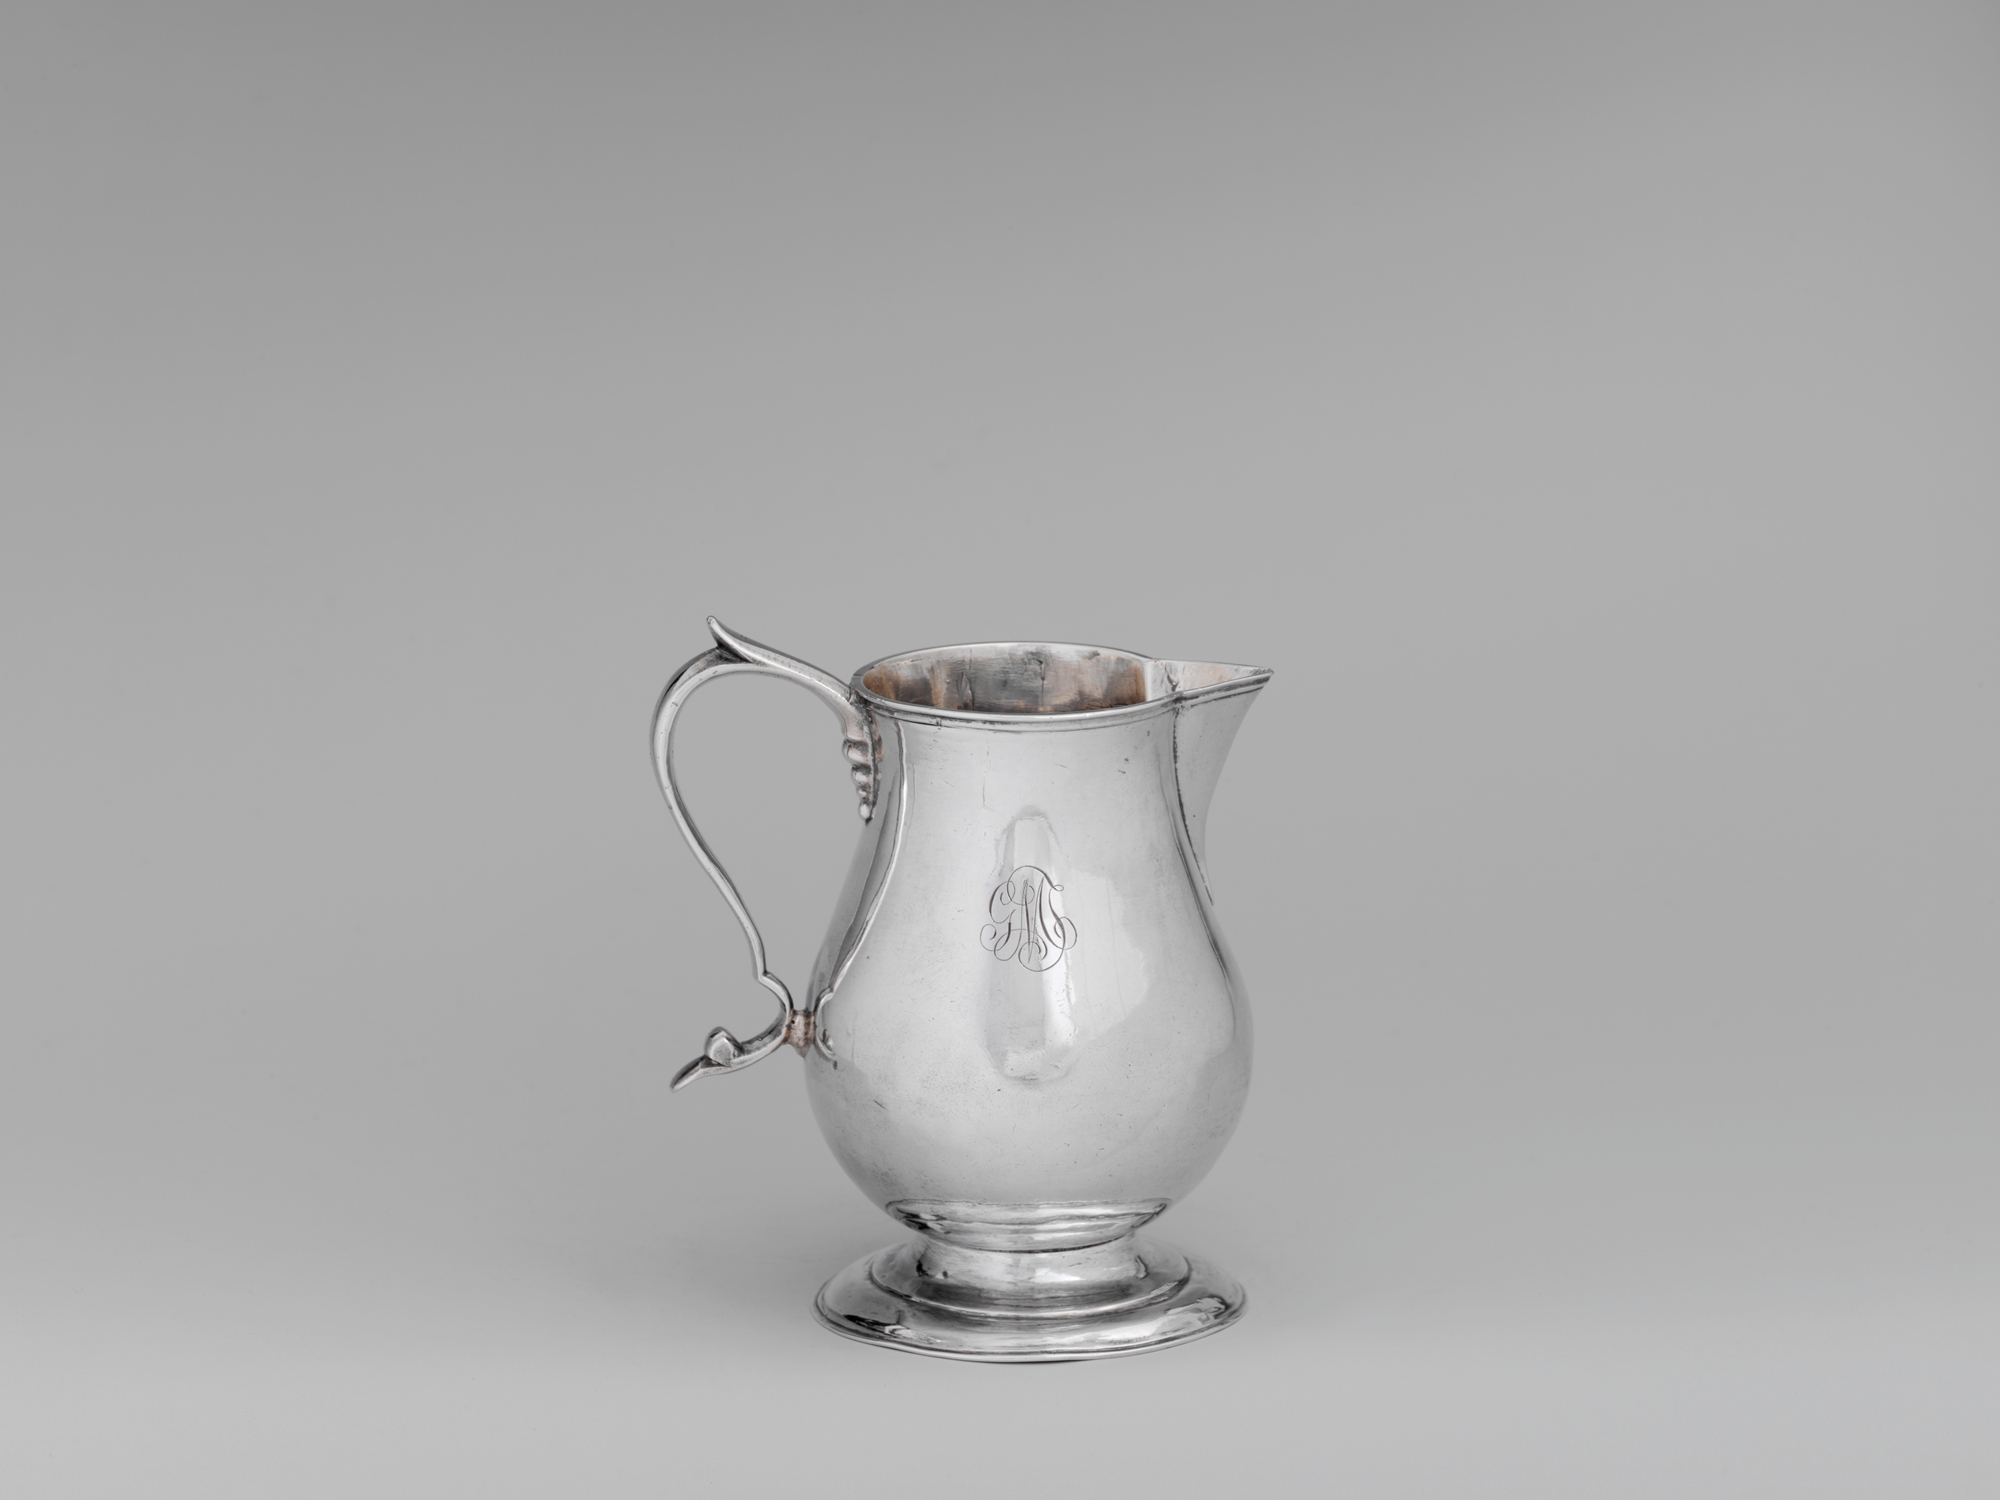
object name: cream pot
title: Creamer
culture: american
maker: jonathan otis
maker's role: maker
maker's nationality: american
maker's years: 1723-1791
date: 1760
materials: silver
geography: united states